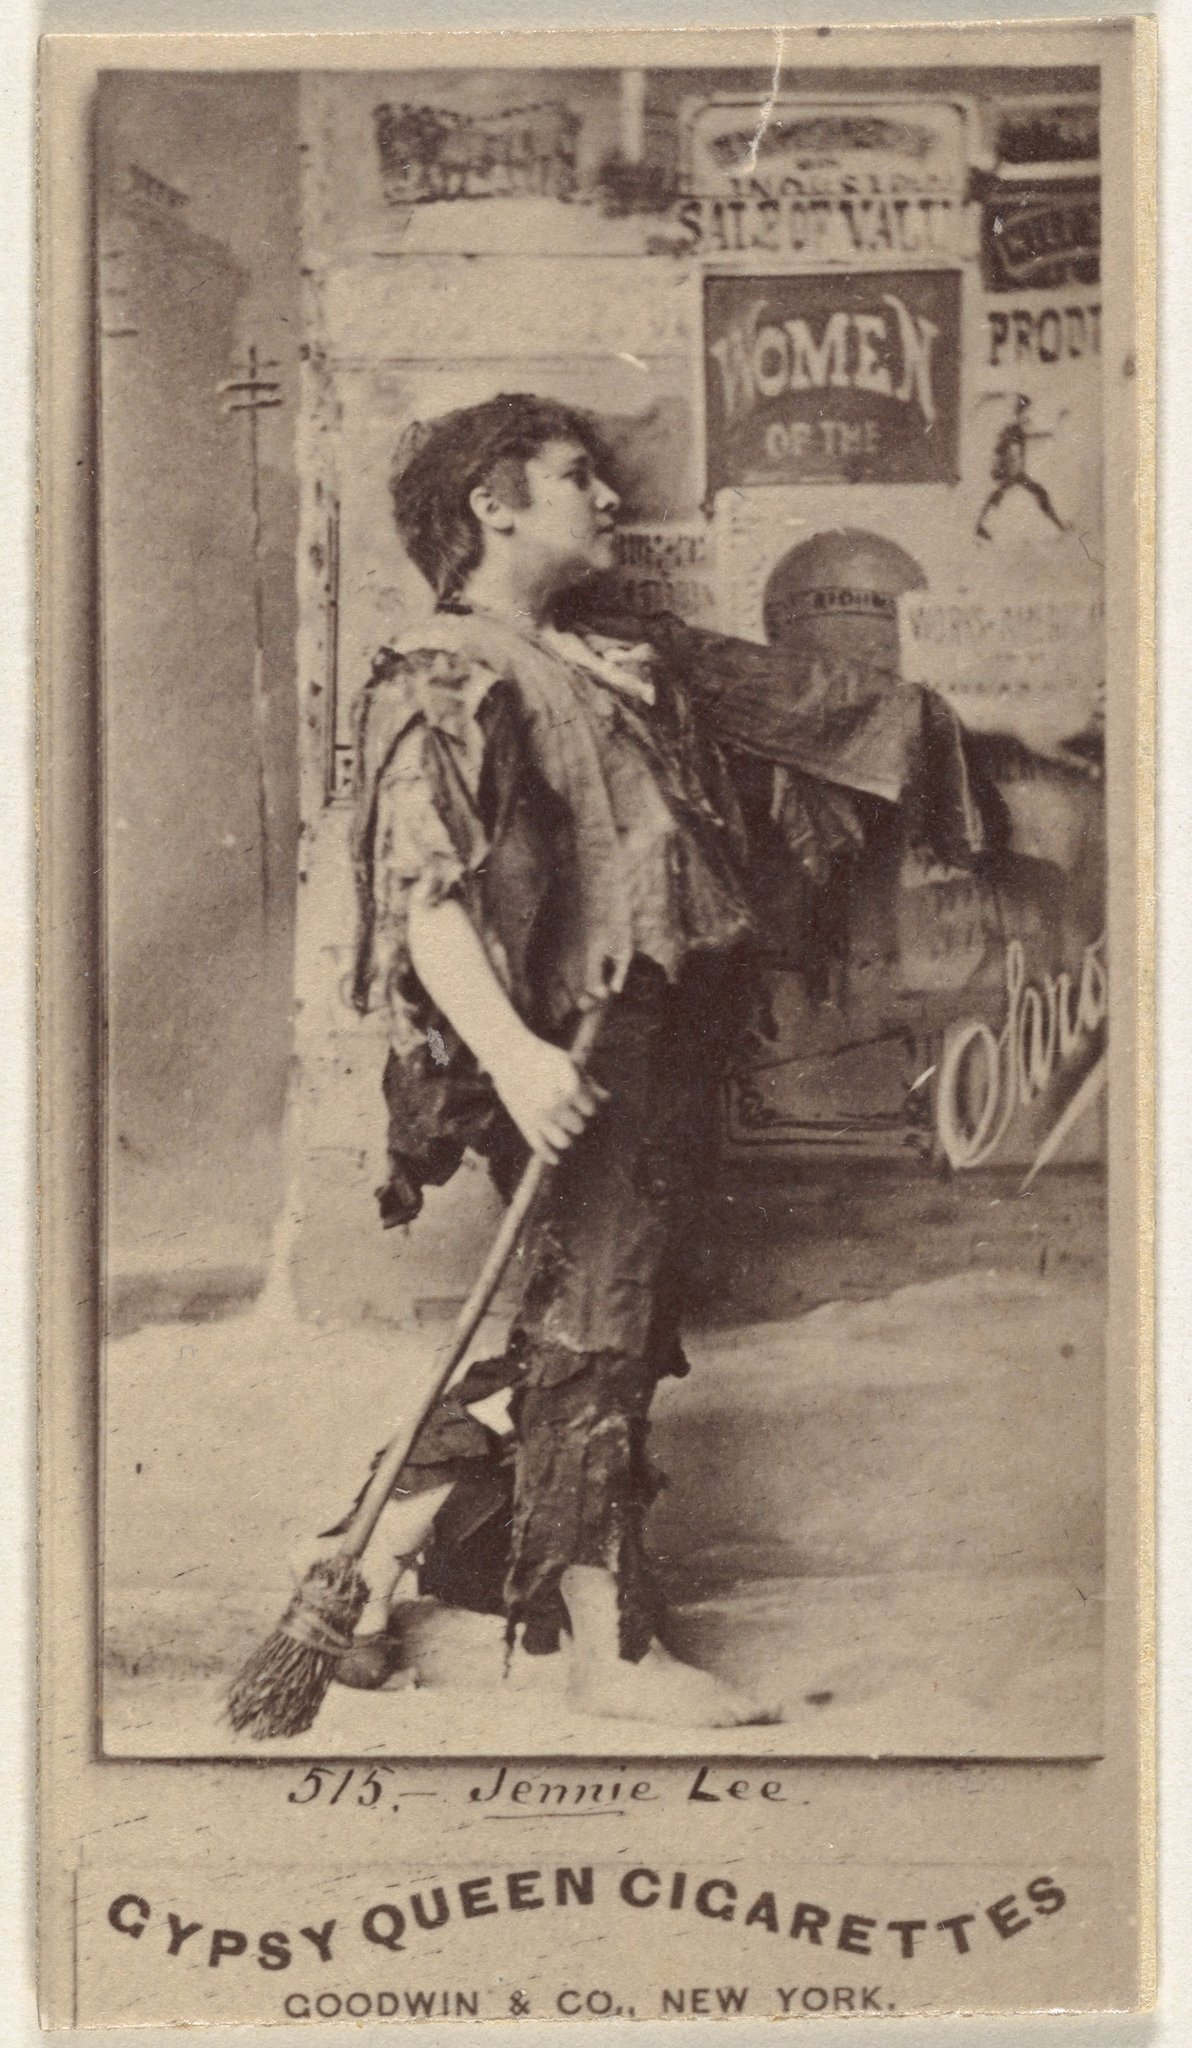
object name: photograph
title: Jennie Lee, from the Actors and Actresses series (N171) for Gypsy Queen Cigarettes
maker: goodwin & company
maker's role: publisher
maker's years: 1850-1950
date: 1886-1890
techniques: albumen silver print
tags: women,actresses,brooms